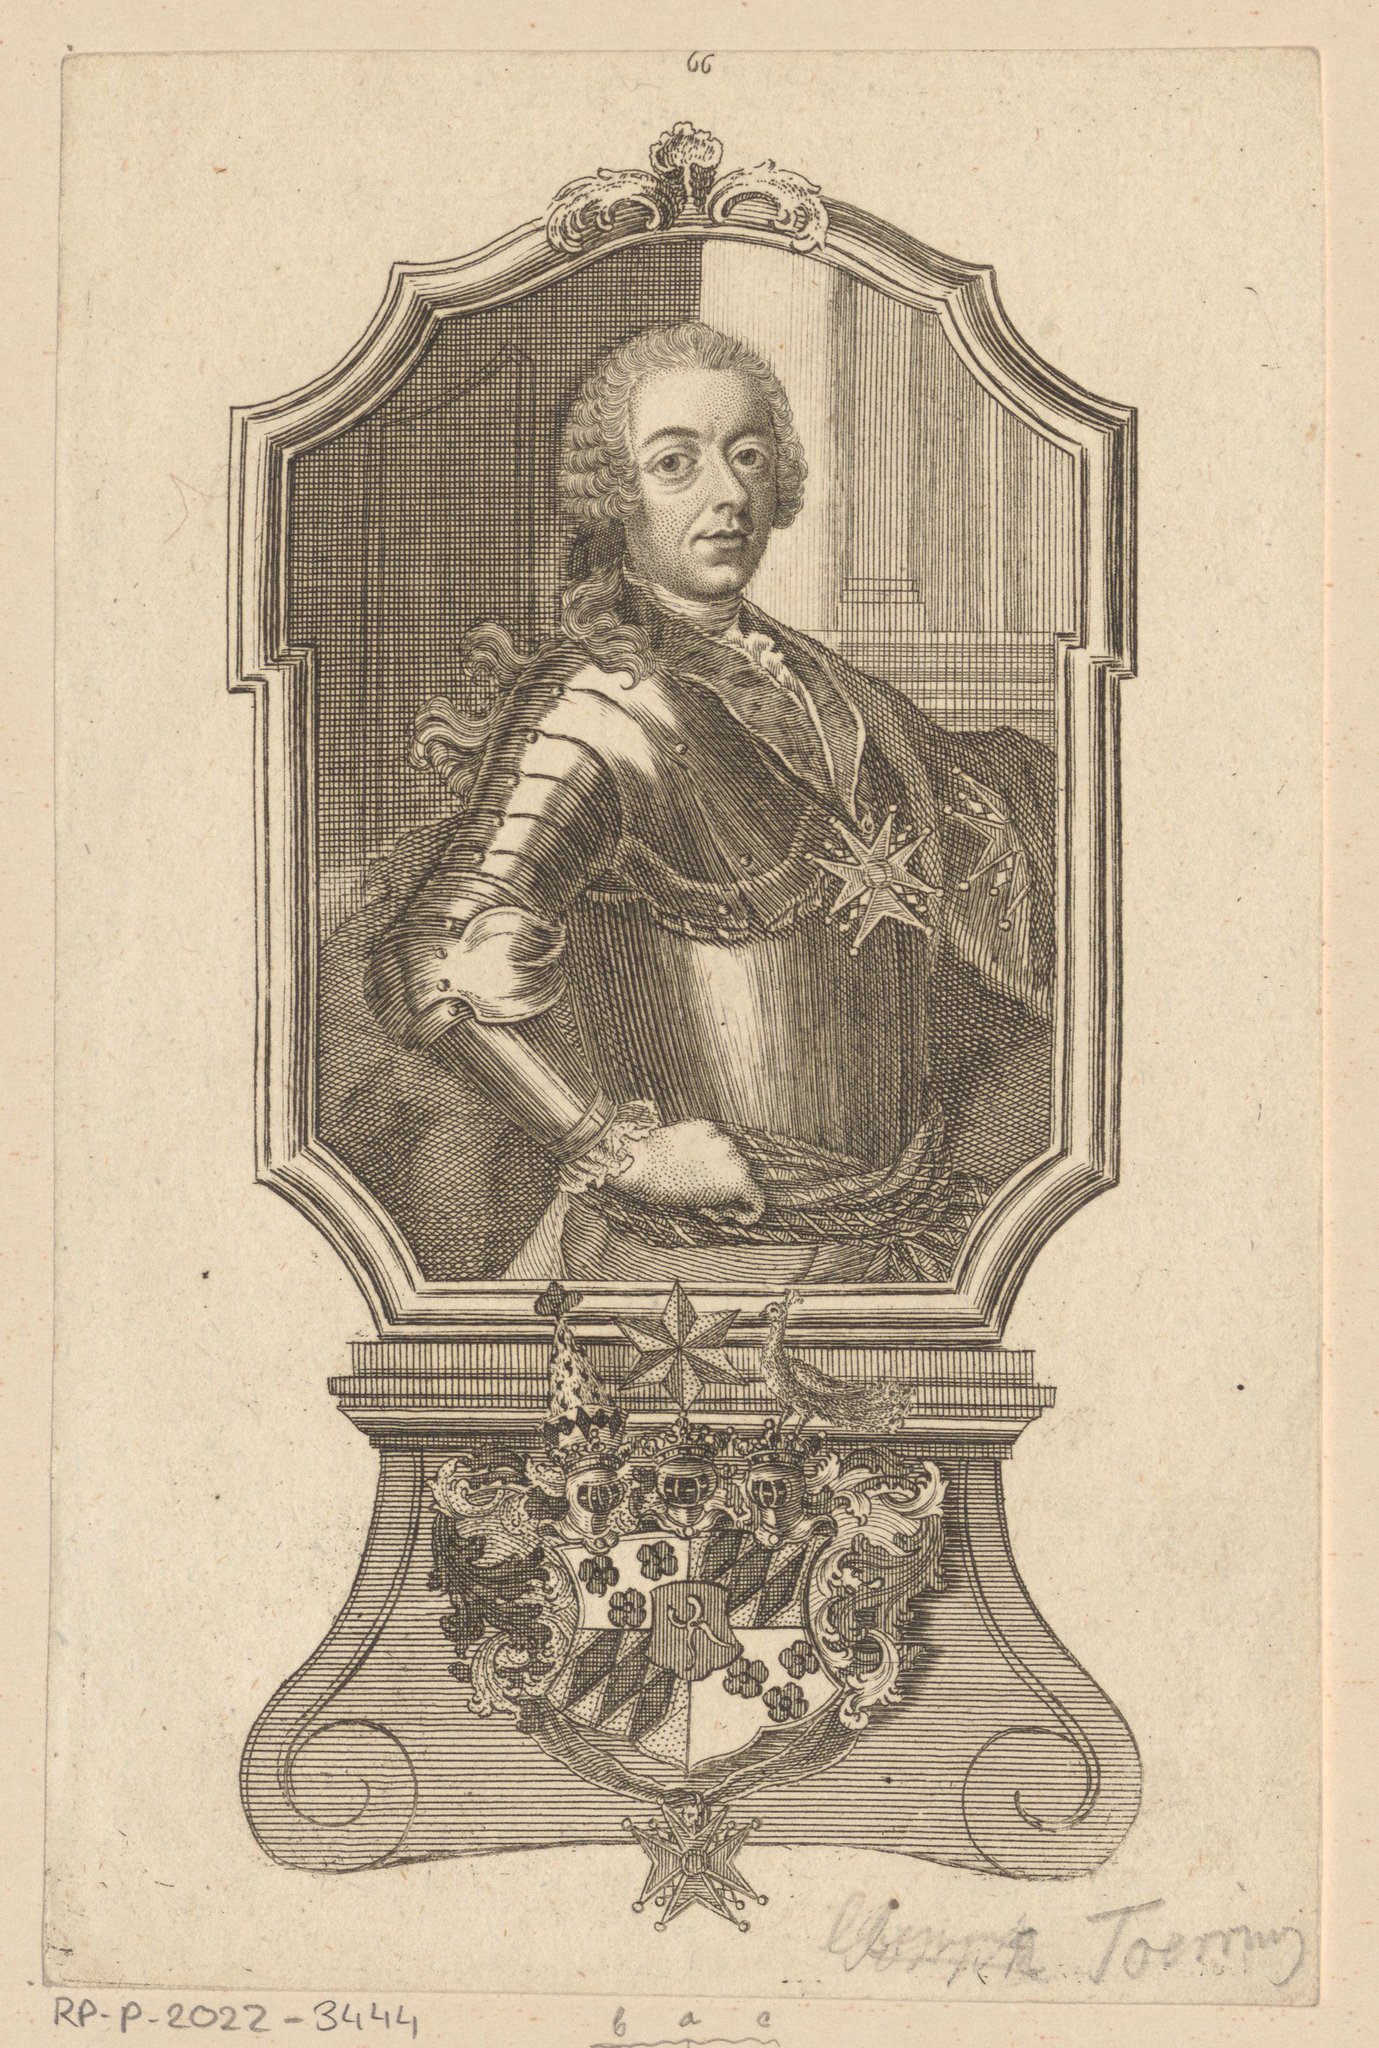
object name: print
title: Portret van Max Emanuel von Toerring-Jettenbach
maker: Anonymous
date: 1750-1799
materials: paper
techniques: etching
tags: historical persons, armorial bearing, heraldry, nobility and patriciate; chivalry, knighthood